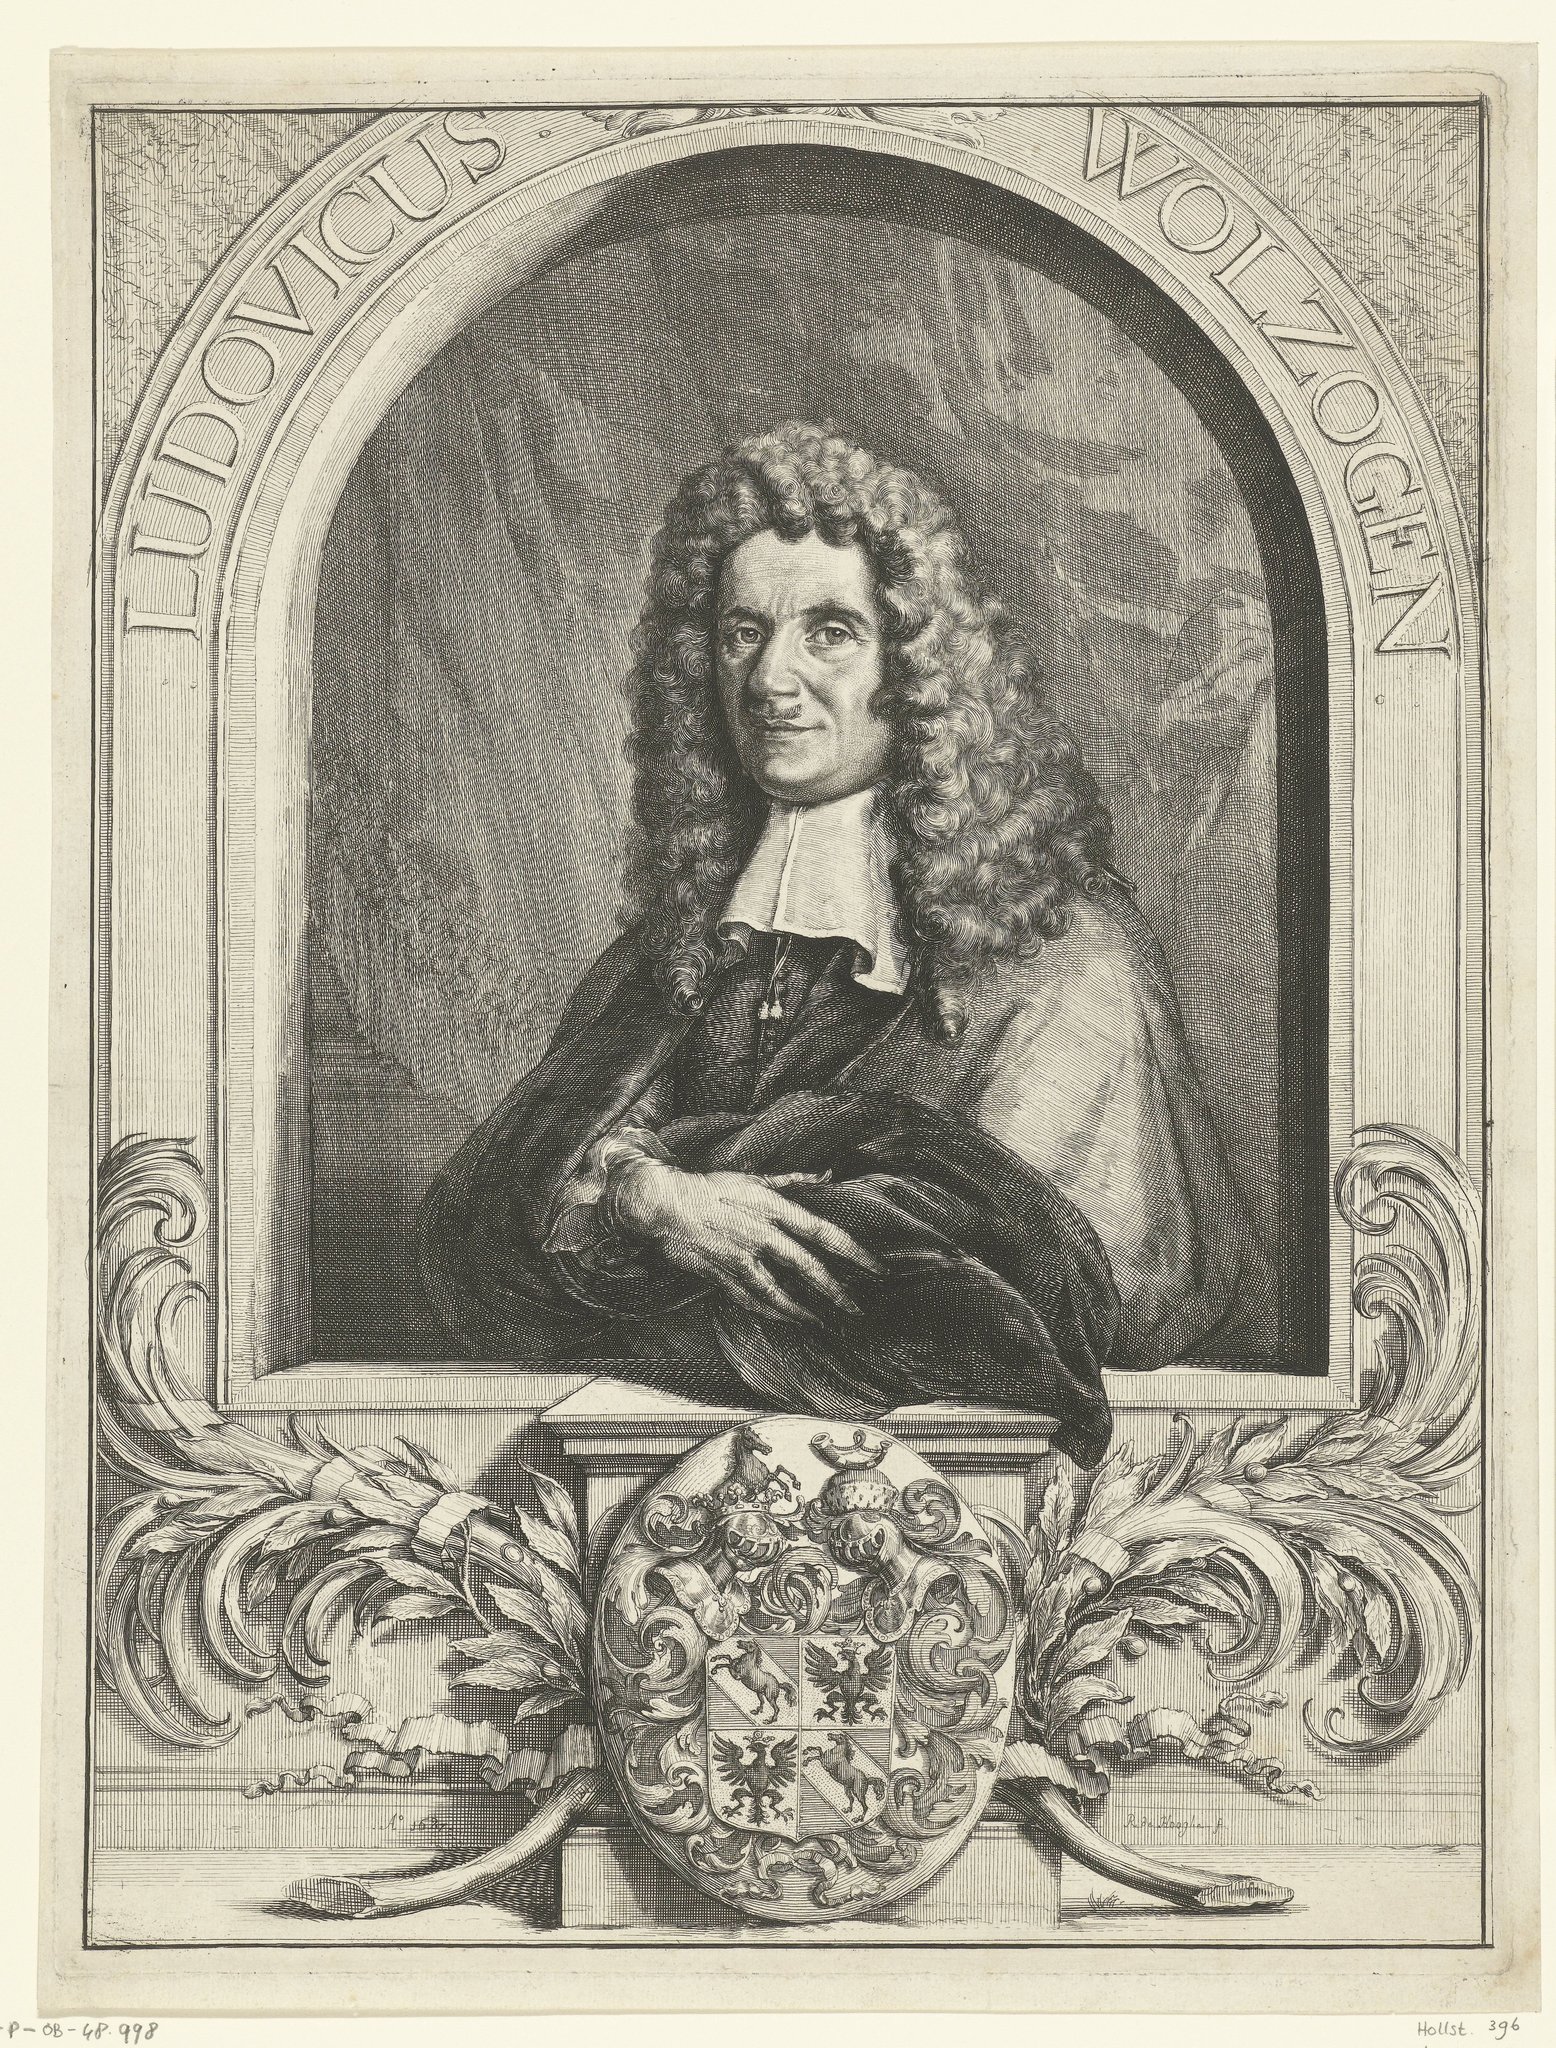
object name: print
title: Ludovicus Wolzogen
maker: romeyn de hooghe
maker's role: draughtsman, goldsmith, painter, print maker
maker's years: 1645-1708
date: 1687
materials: paper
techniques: etching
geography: netherlands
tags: amersfoort, ludovicus wolzogen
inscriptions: date